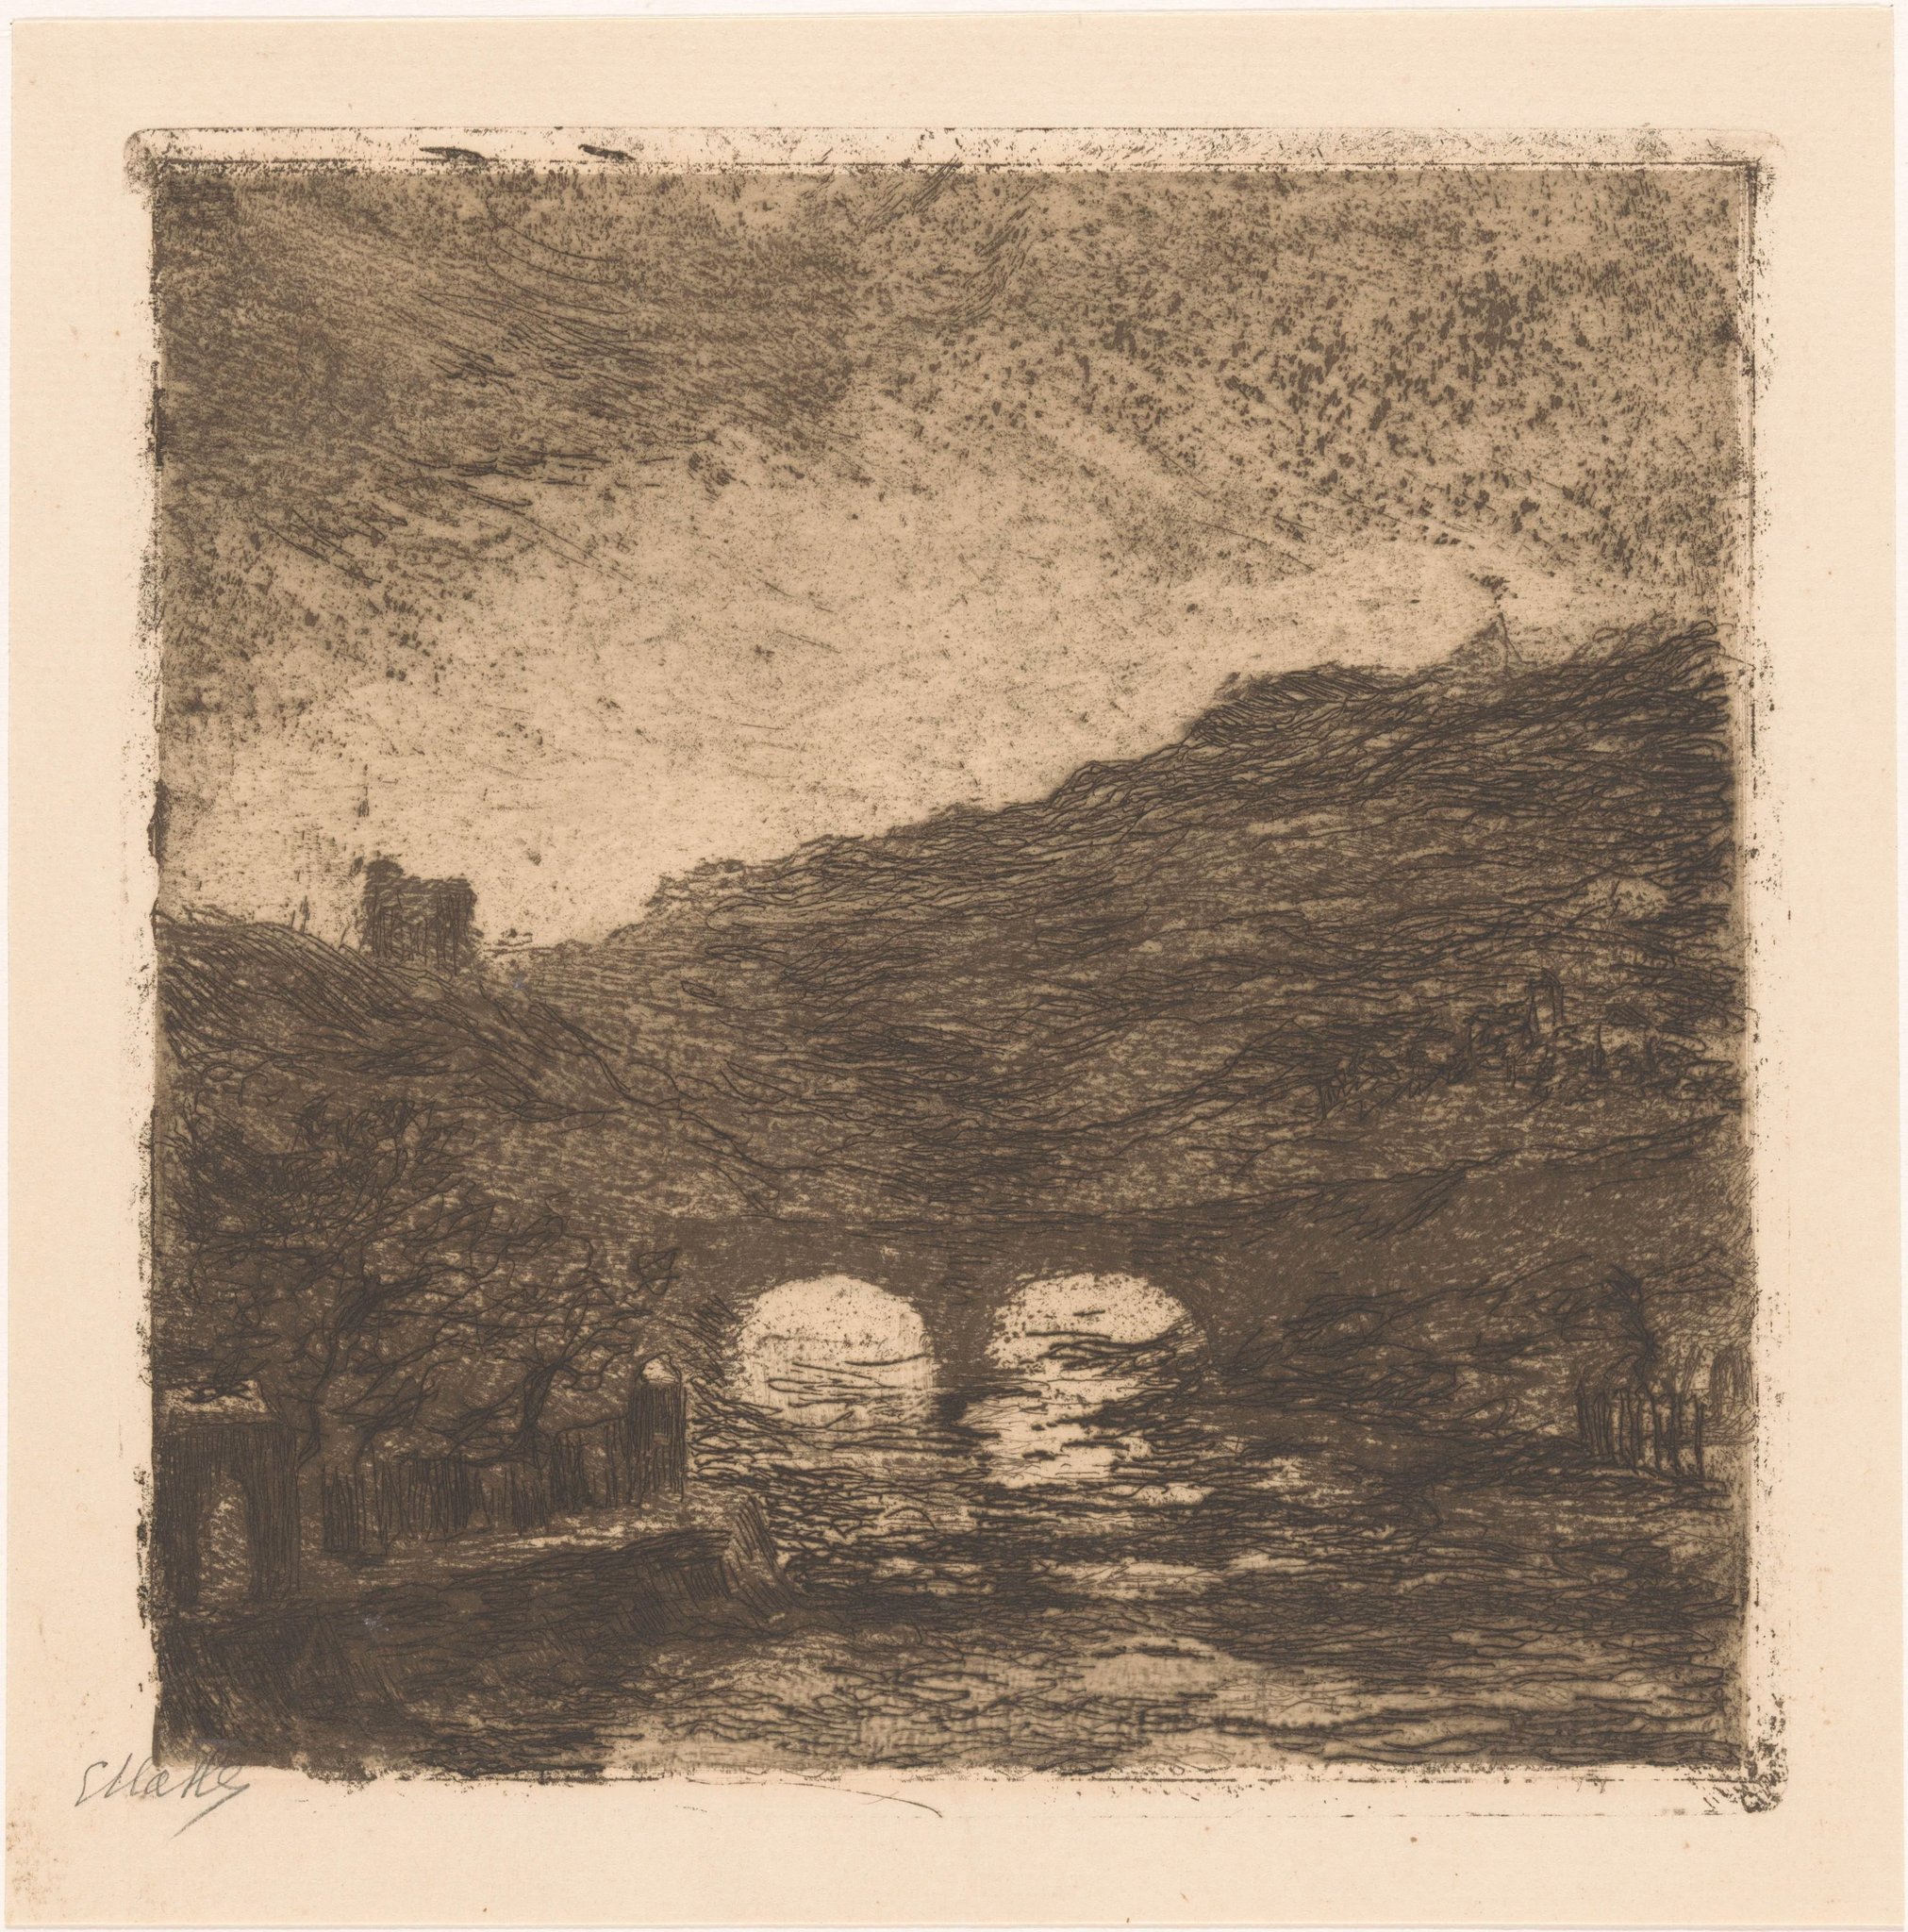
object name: print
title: In de Pyreneeën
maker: etha fles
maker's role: print maker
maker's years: 1857-1948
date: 1867-1910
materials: paper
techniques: drypoint, soft ground etching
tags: bridge, mountains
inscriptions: collector's mark: Lugt 2228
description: Een brug over een rivier in een berglandschap.